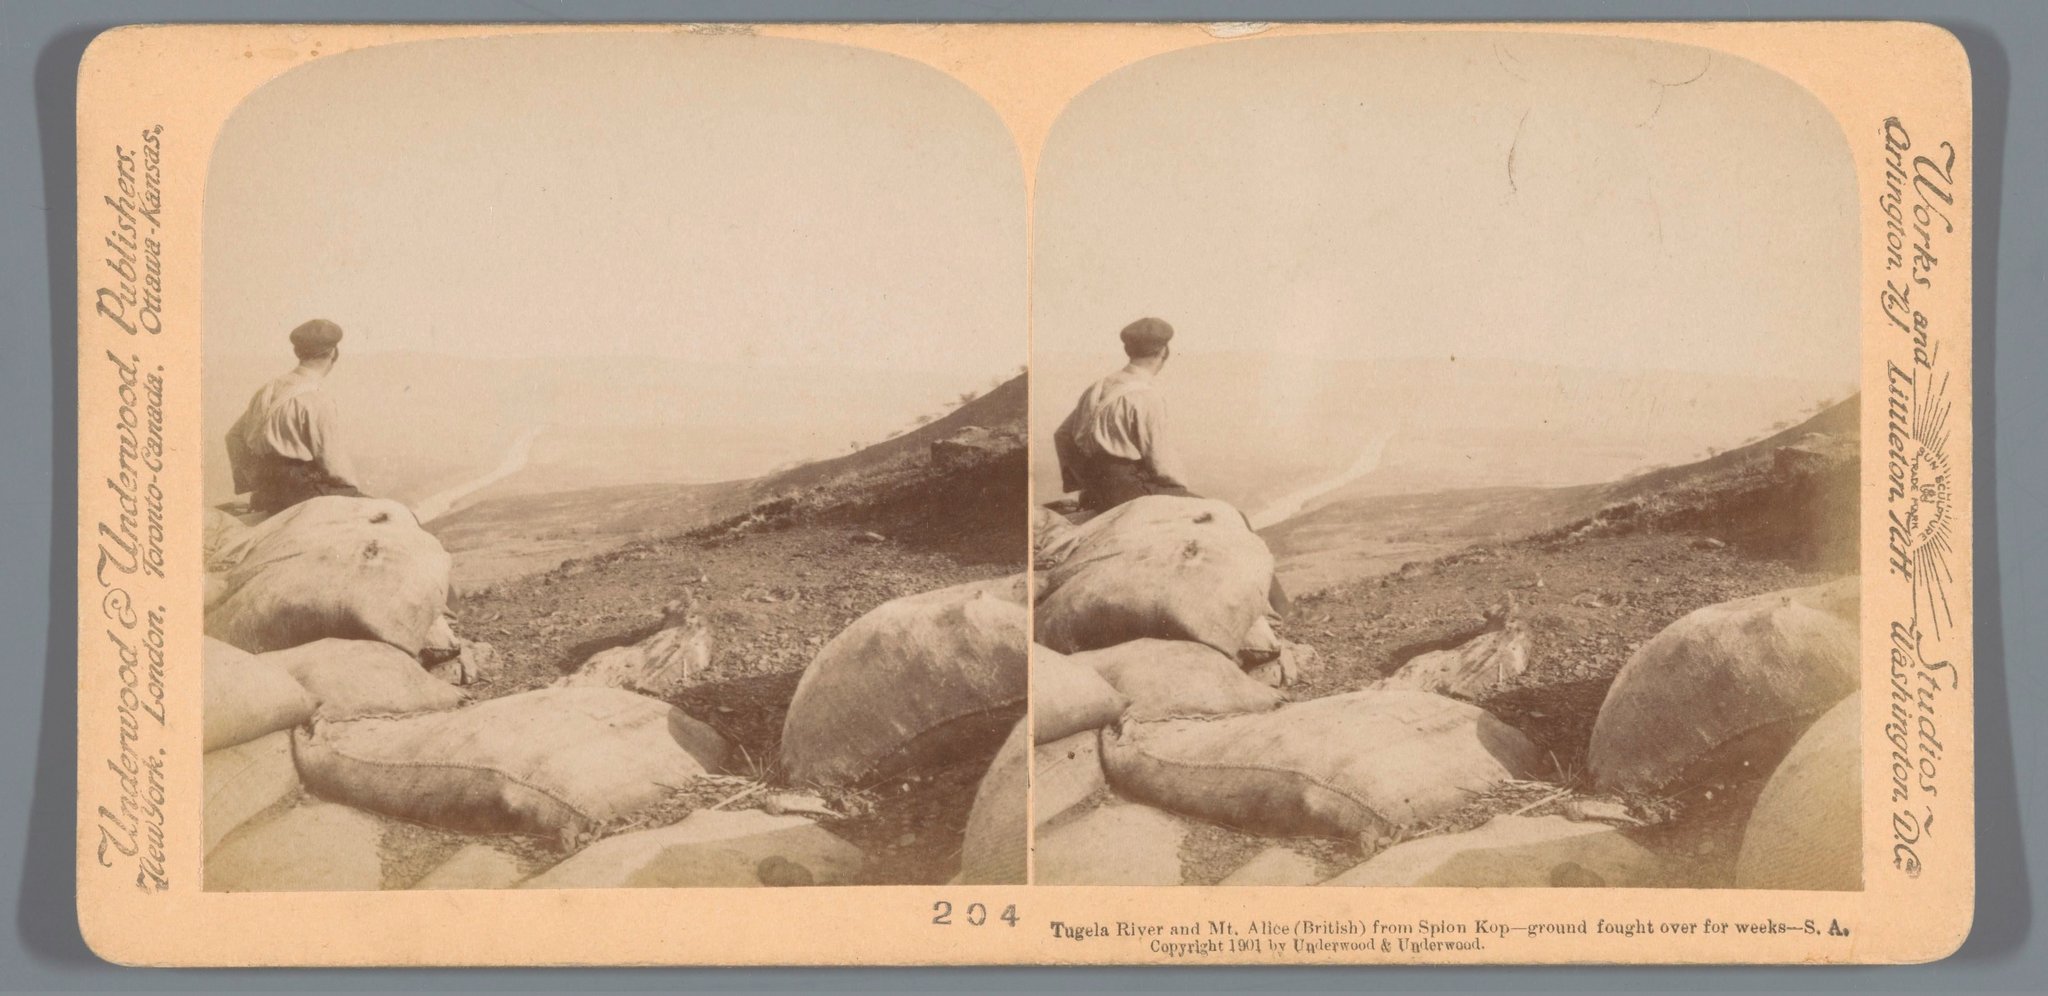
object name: stereograph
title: Gezicht op de Tugelarivier en Mount Alice vanaf Spionkop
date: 1901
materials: cardboard, photographic support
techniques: albumen print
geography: spionkop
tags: river, mountains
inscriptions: number: ‘204’, name: ‘Works and Studios Sun Sculpture trade mark Arlington N.J. Littleton N.H. Washington D.C.’